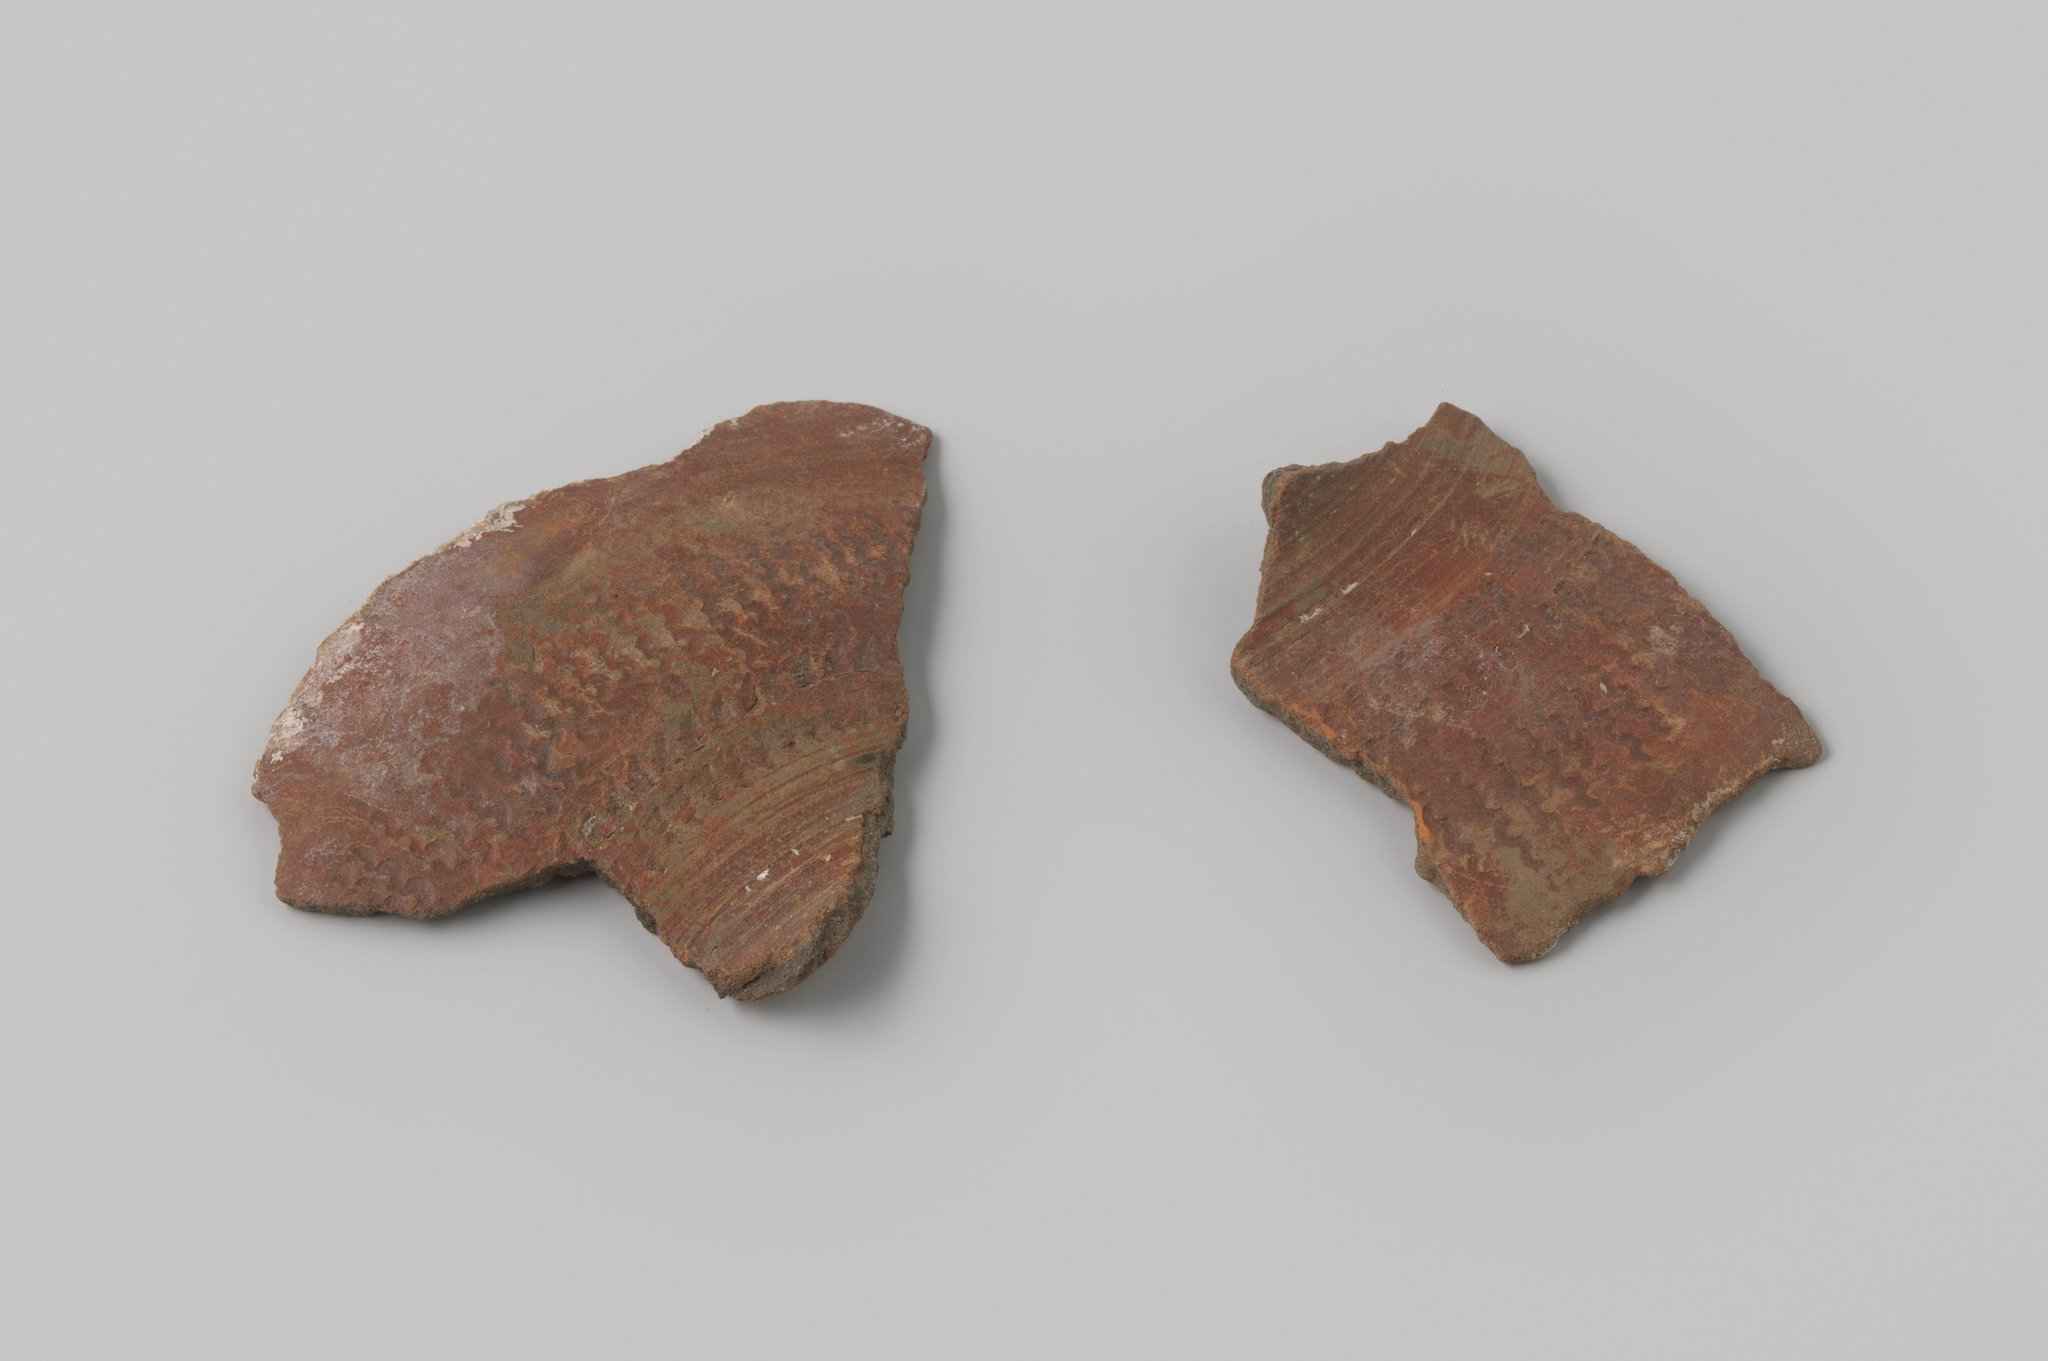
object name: sherd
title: Twee scherven van aardewerk uit V.O.C.-schip de 'Witte Leeuw'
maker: Anonymous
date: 1613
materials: earthenware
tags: verenigde oostindische compagnie, sint-helena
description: Twee scherven van één pot uit V.O.C.-schip de 'Witte Leeuw'